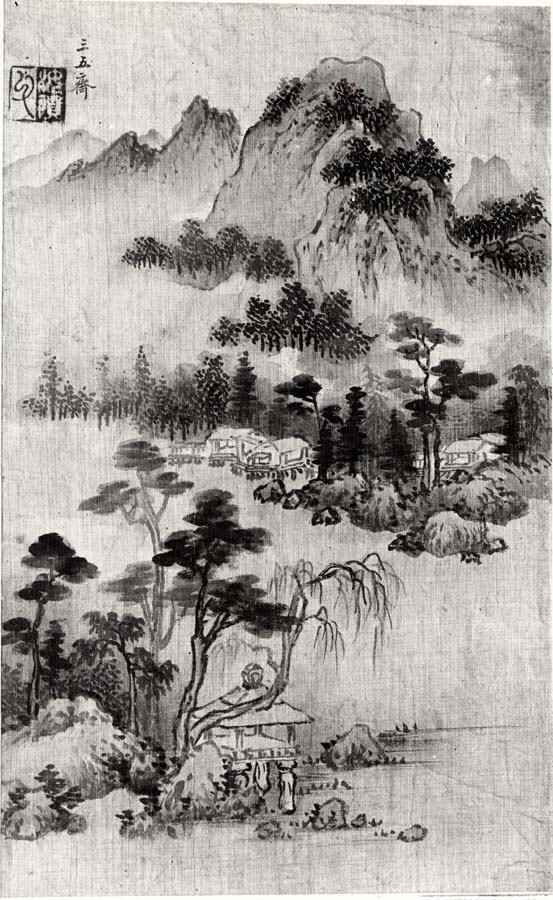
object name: painting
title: Pavilion by the Lake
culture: korean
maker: samoje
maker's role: artist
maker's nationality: korean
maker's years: 1771-1779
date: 1767-1800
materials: hemp, ink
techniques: painting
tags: mountains,landscapes